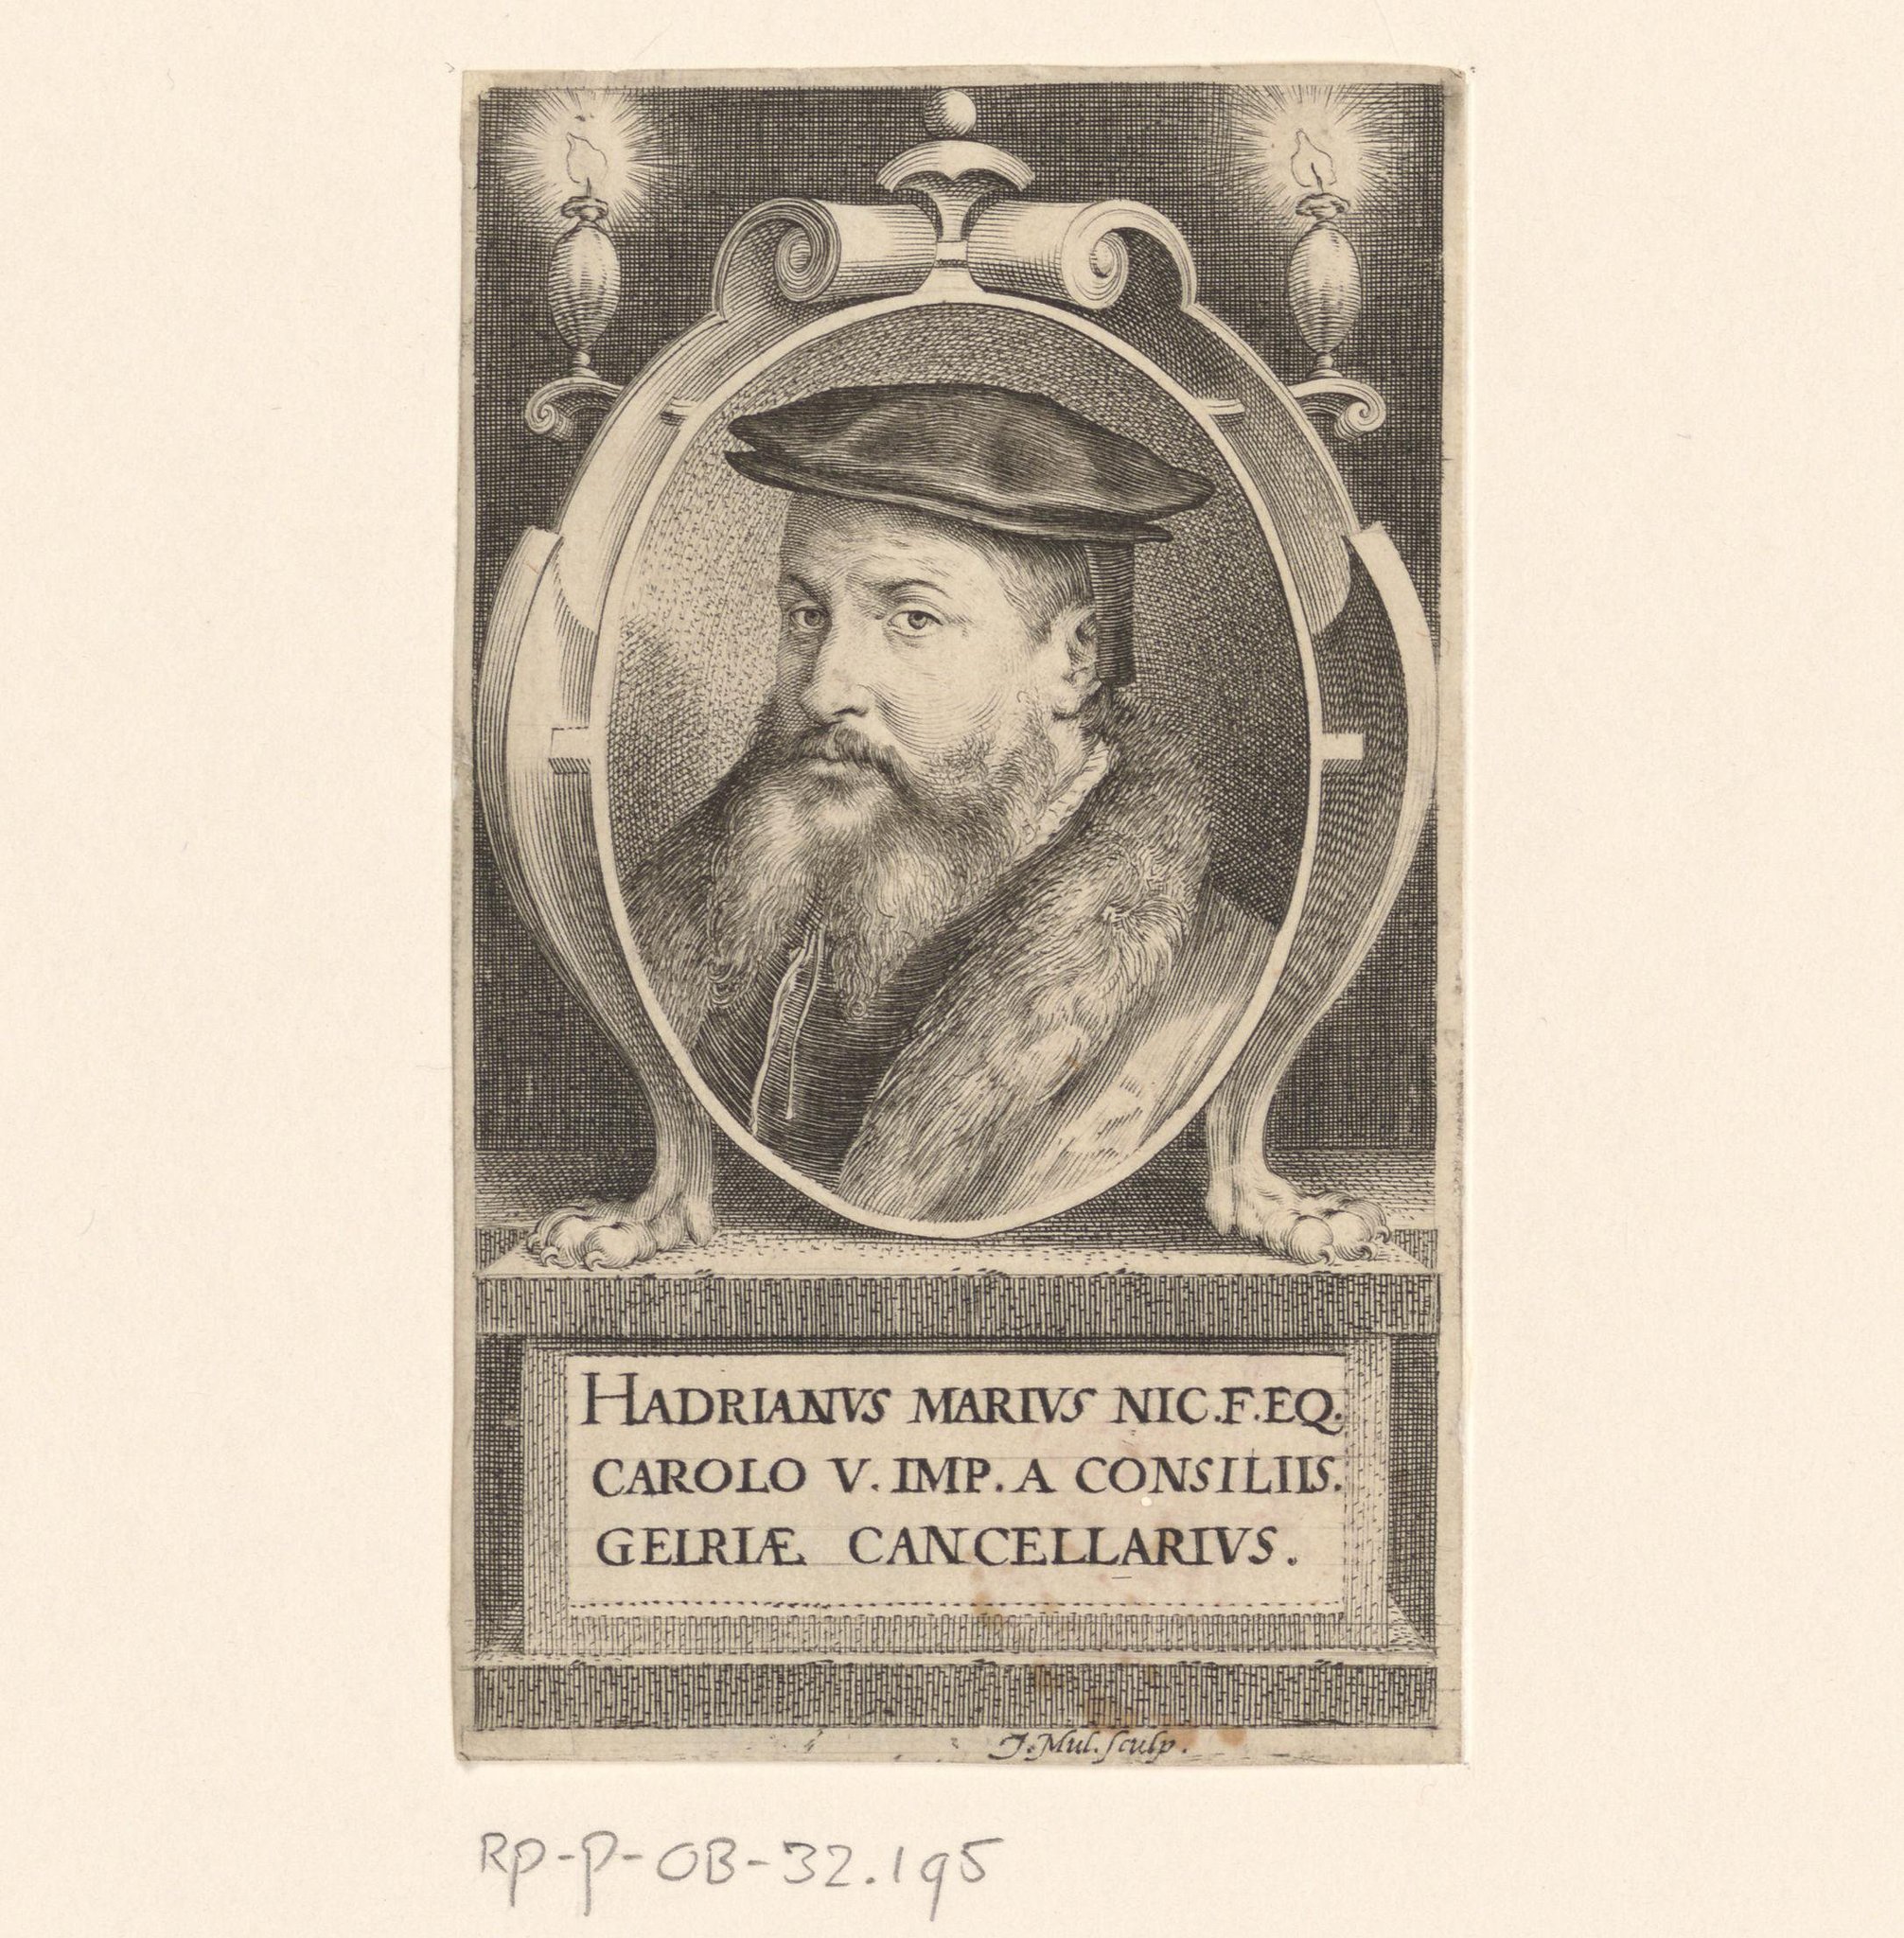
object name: print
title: Portret van Hadrianus Marius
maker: jan harmensz. muller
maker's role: draughtsman, print maker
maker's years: 1571-1628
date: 1612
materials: paper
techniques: engraving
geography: amsterdam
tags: mechelen, hadrianus marius, ornament ~ medallion, historical persons, portrait of a writer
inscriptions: collector's mark: Lugt 240